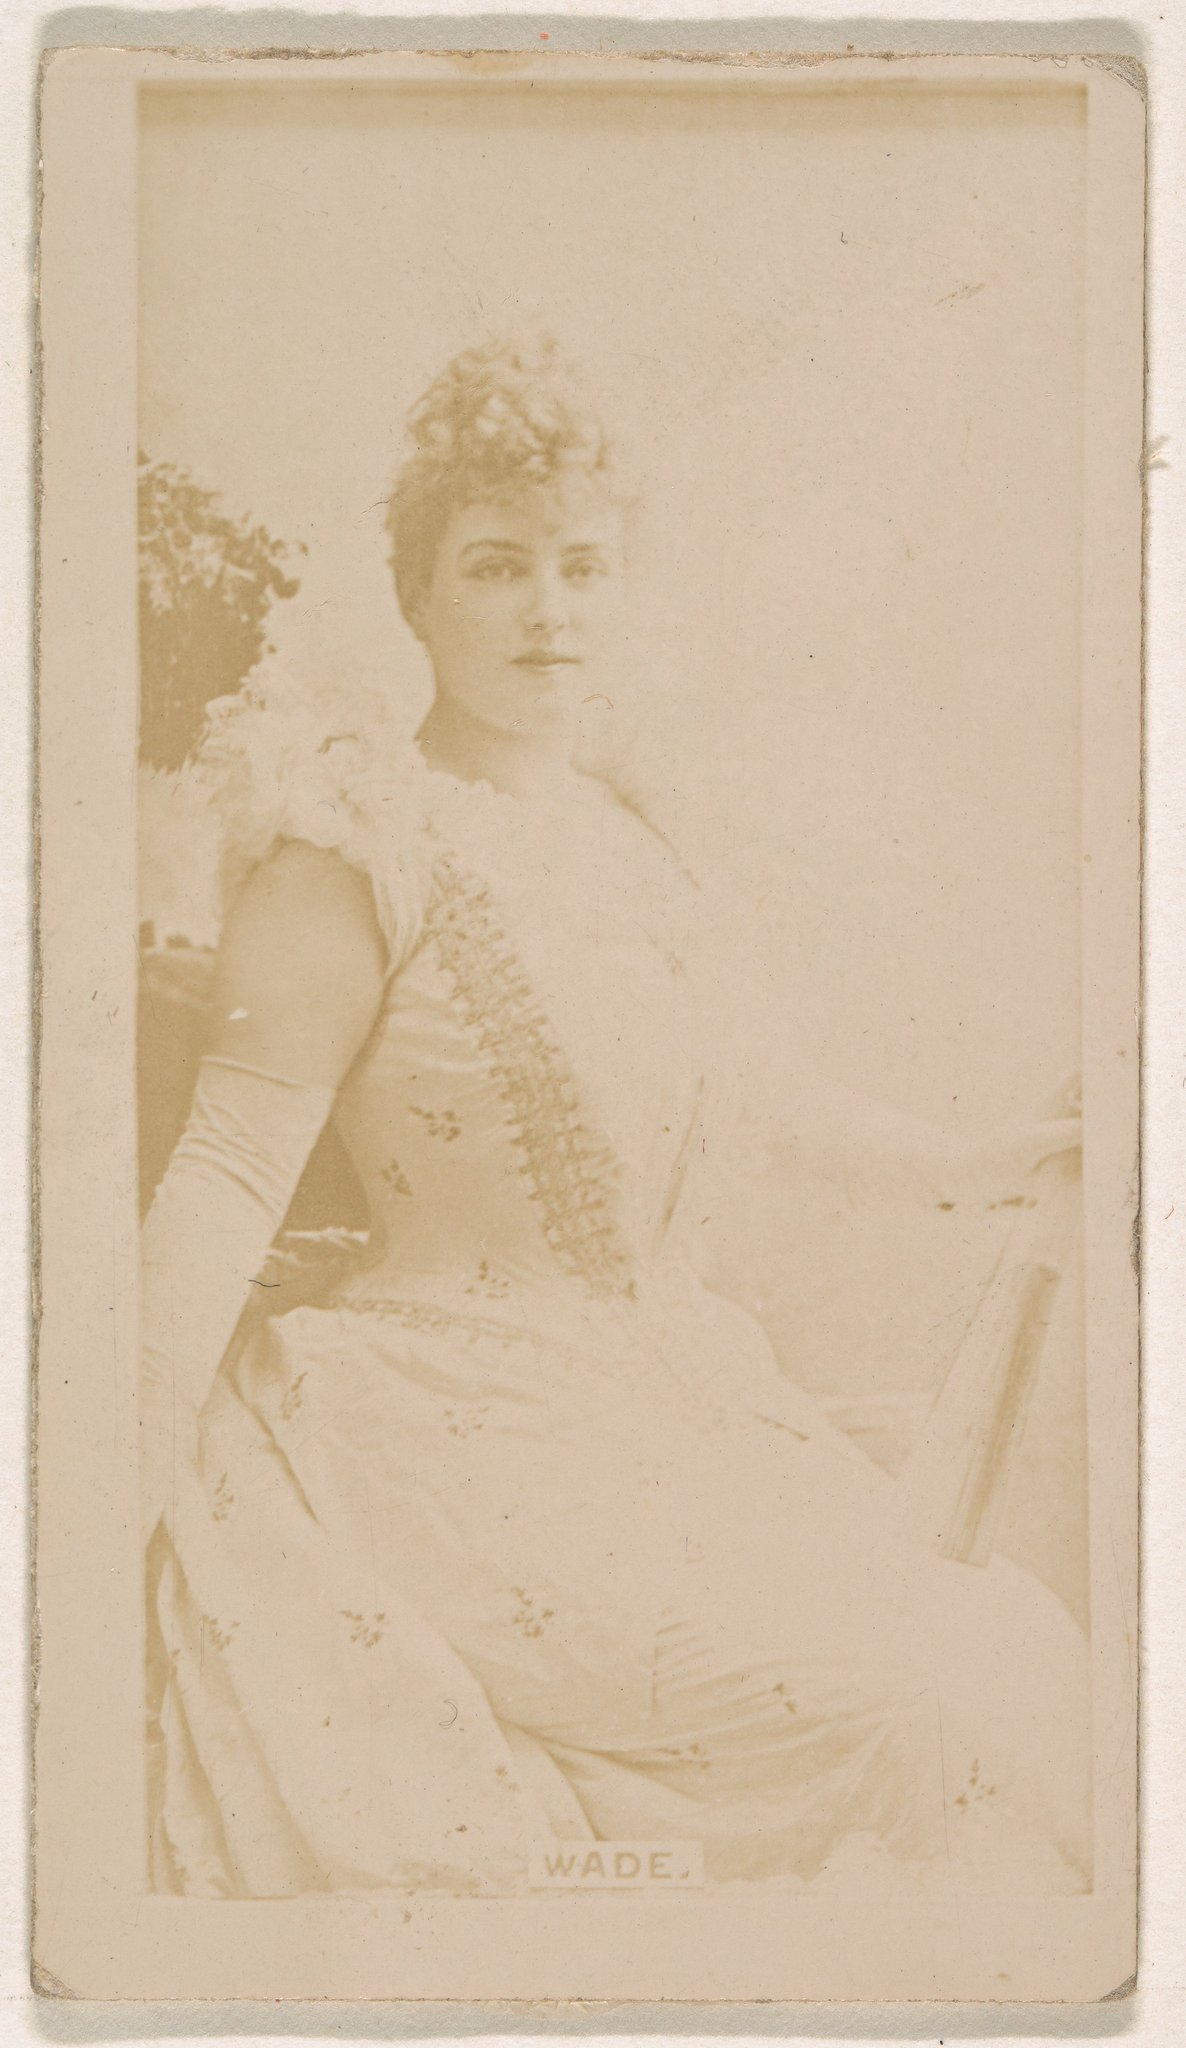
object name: photograph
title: Miss Wade, from the Actresses series (N245) issued by Kinney Brothers to promote Sweet Caporal Cigarettes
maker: kinney brothers tobacco company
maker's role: publisher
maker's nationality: american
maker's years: 1869-2011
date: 1890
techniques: albumen silver print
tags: portraits,women,actresses